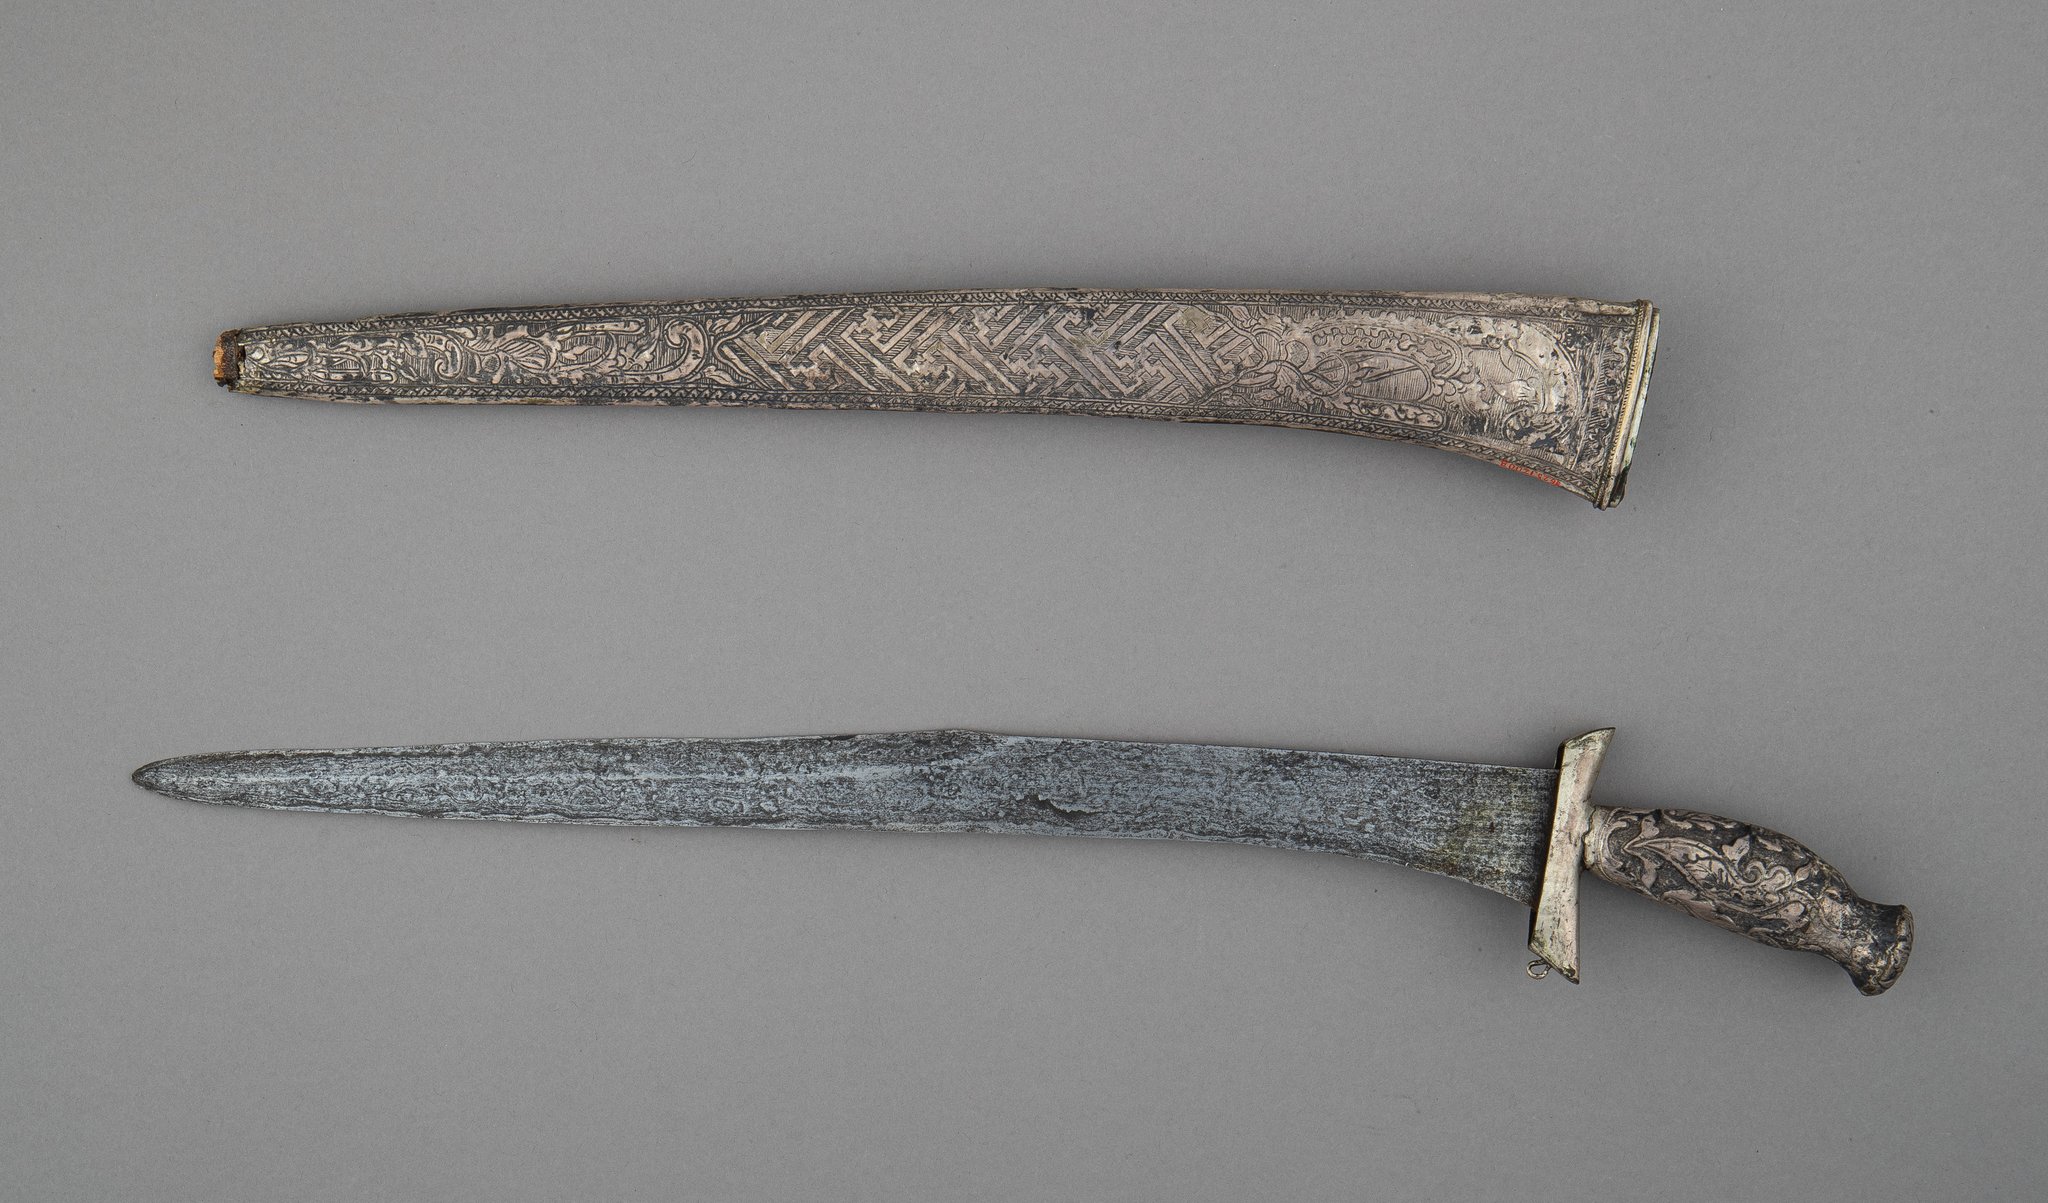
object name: kris with sheath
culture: javanese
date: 1501-1900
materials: paste, silver, steel, wood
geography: indonesia